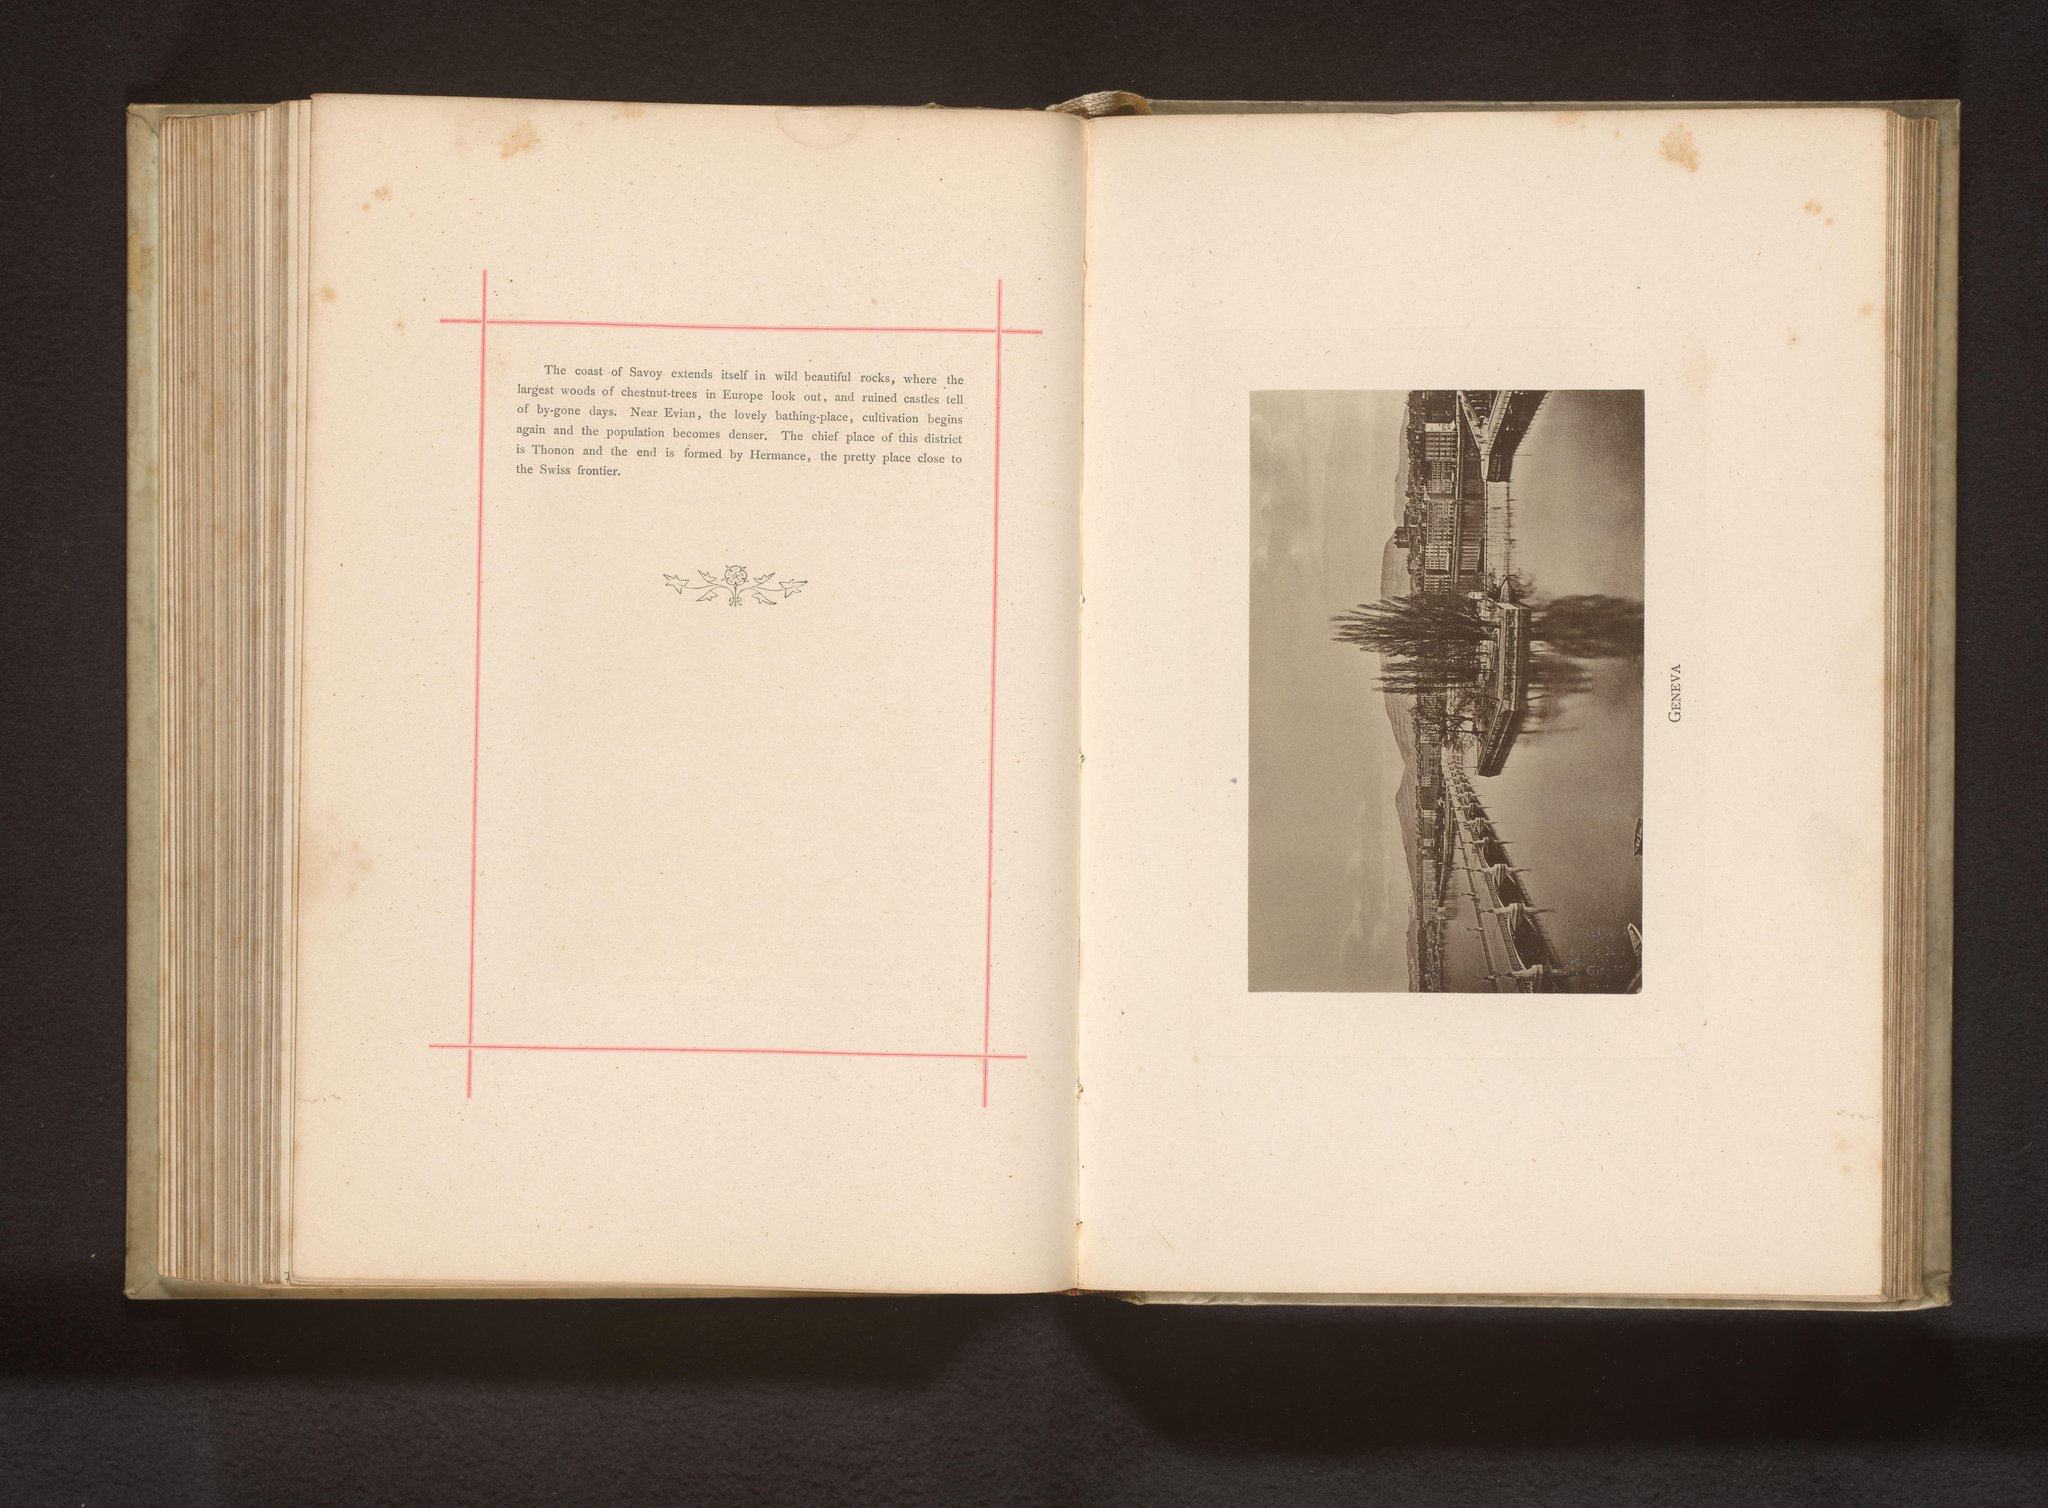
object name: photomechanical print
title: Gezicht op Genève met de Pont du Mont-Blanc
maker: Anonymous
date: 1874-1884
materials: paper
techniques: photograph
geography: geneva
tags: city-view in general; 'veduta', bridge in city across river, canal, etc.